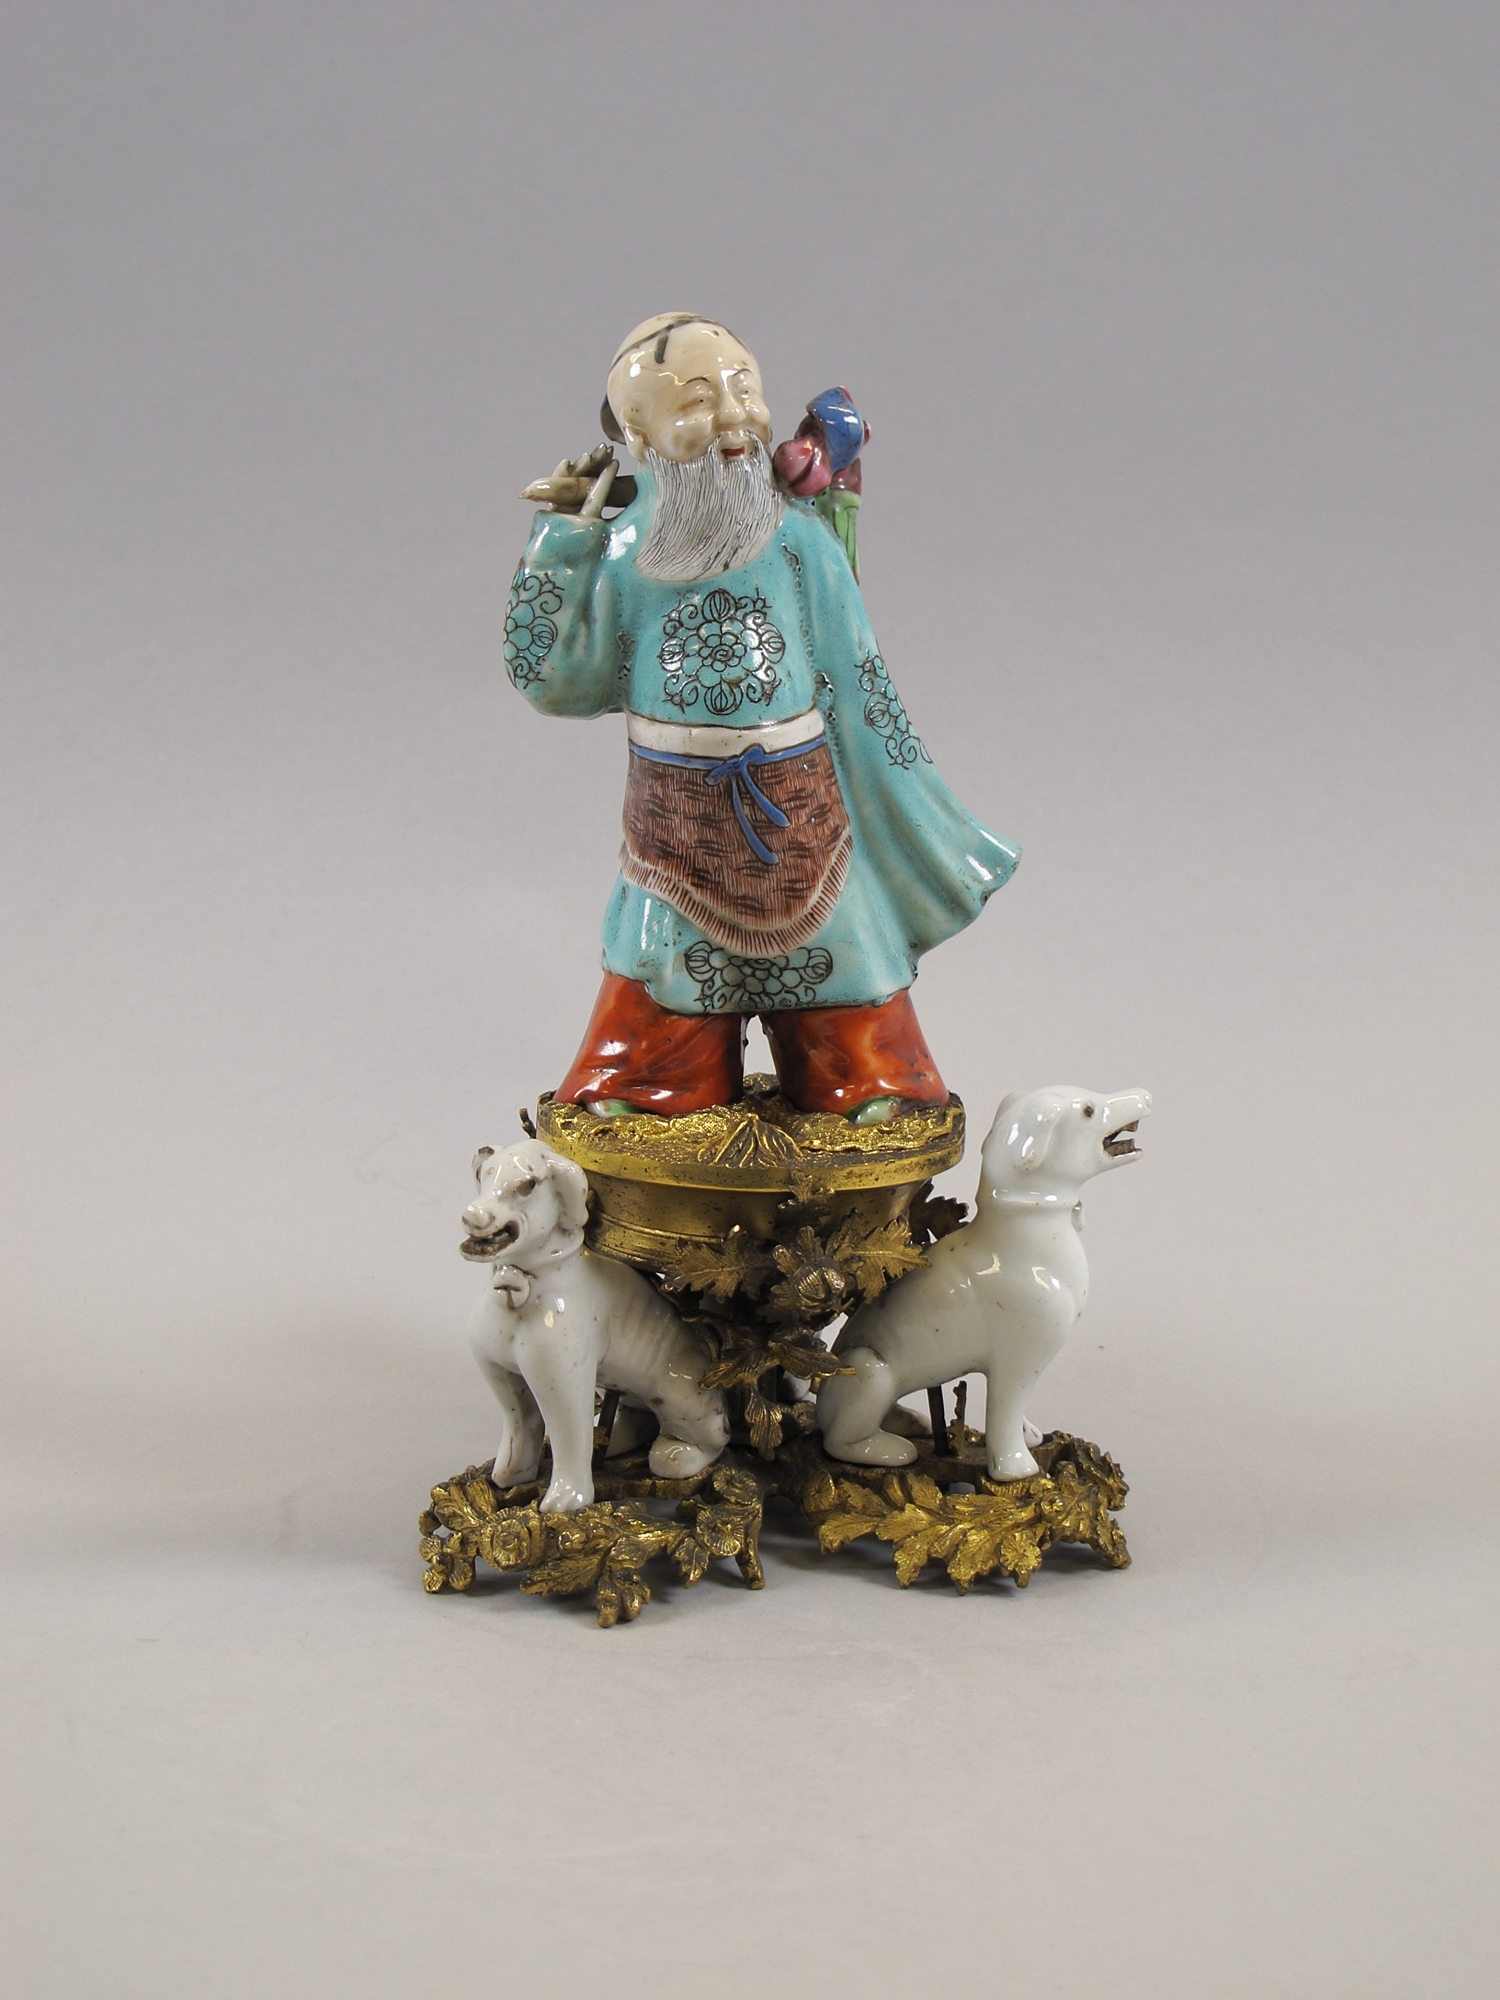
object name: figure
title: Figure of God of Longevity (Shoulao) and two dogs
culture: chinese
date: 1701-1800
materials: enamel, gilt bronze, porcelain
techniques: overglaze, painting, polychrome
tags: men,dogs